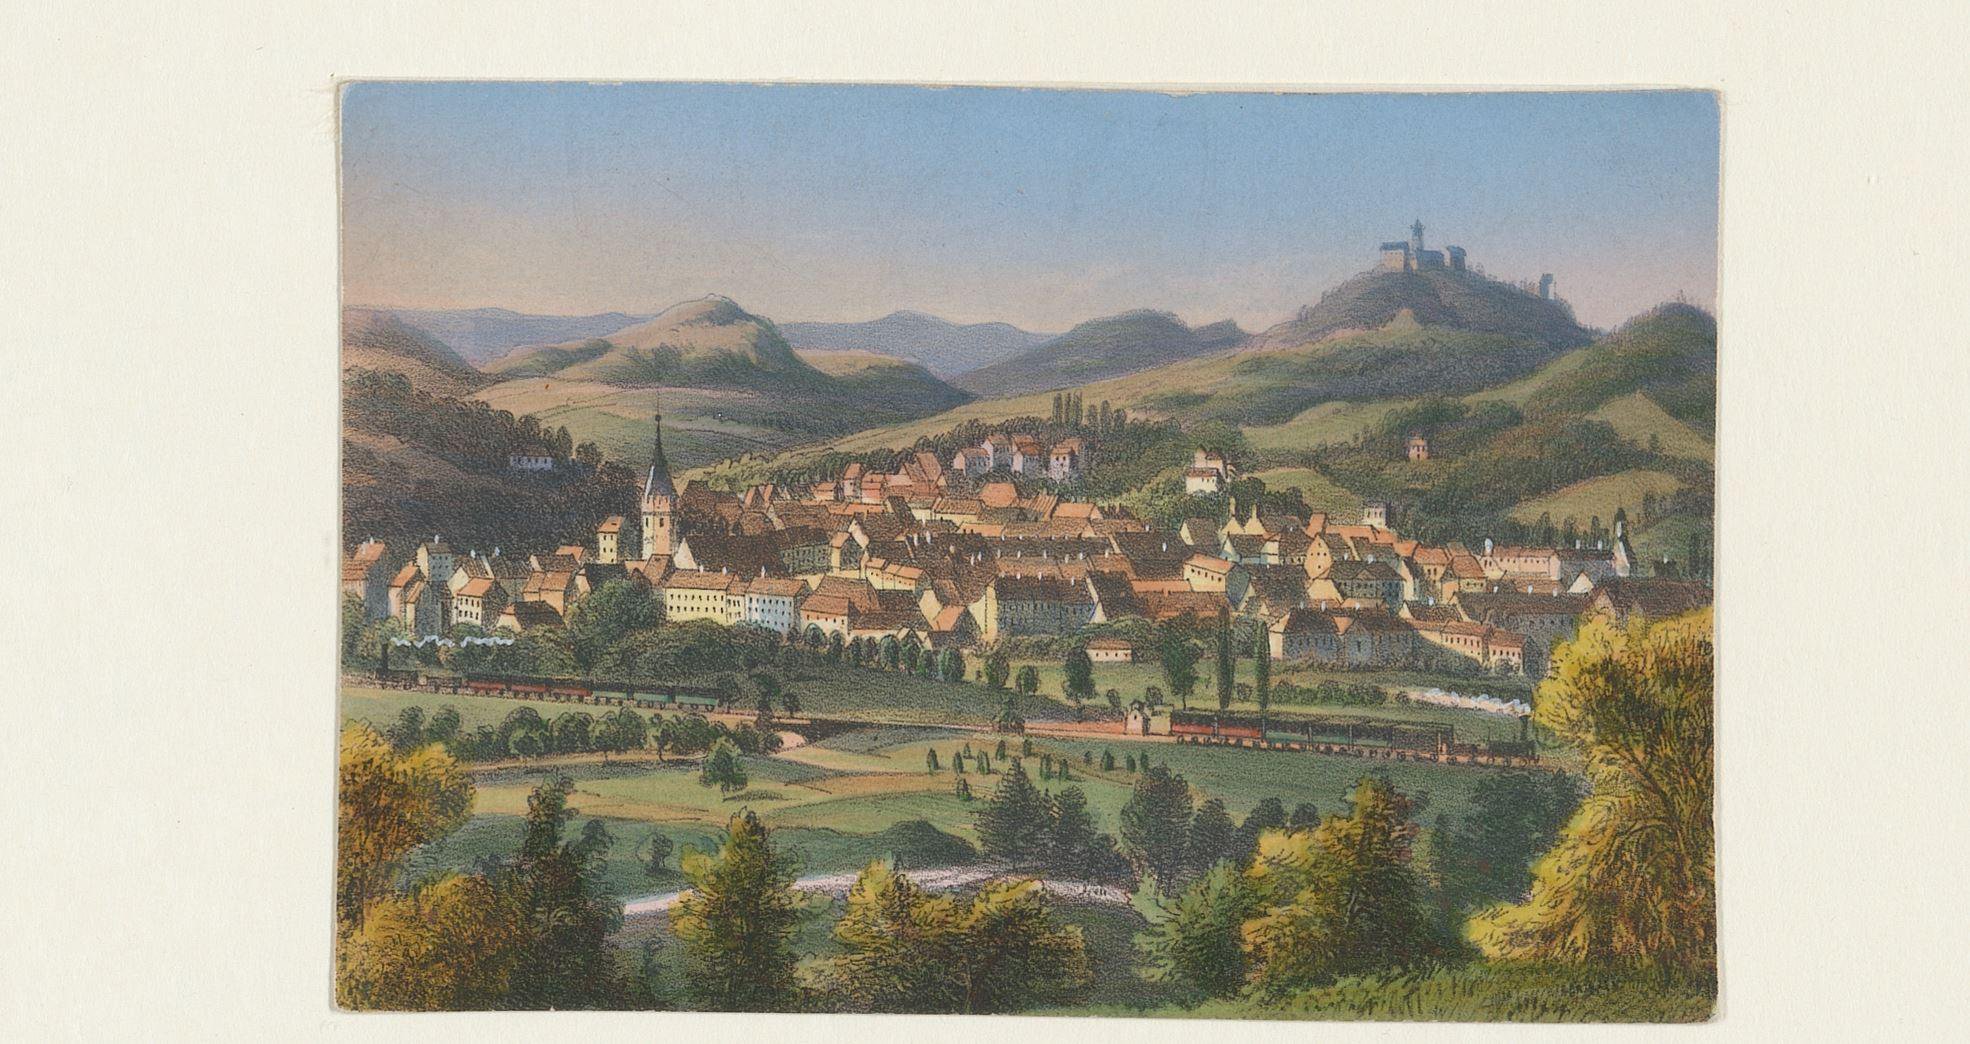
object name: print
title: Eisenach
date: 1846-1913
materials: paper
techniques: lithograph, hand coloring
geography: dresden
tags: prospect of village, silhouette of village, (high) hill - hh - ideal landscapes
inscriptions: collector's mark: Lugt 2228